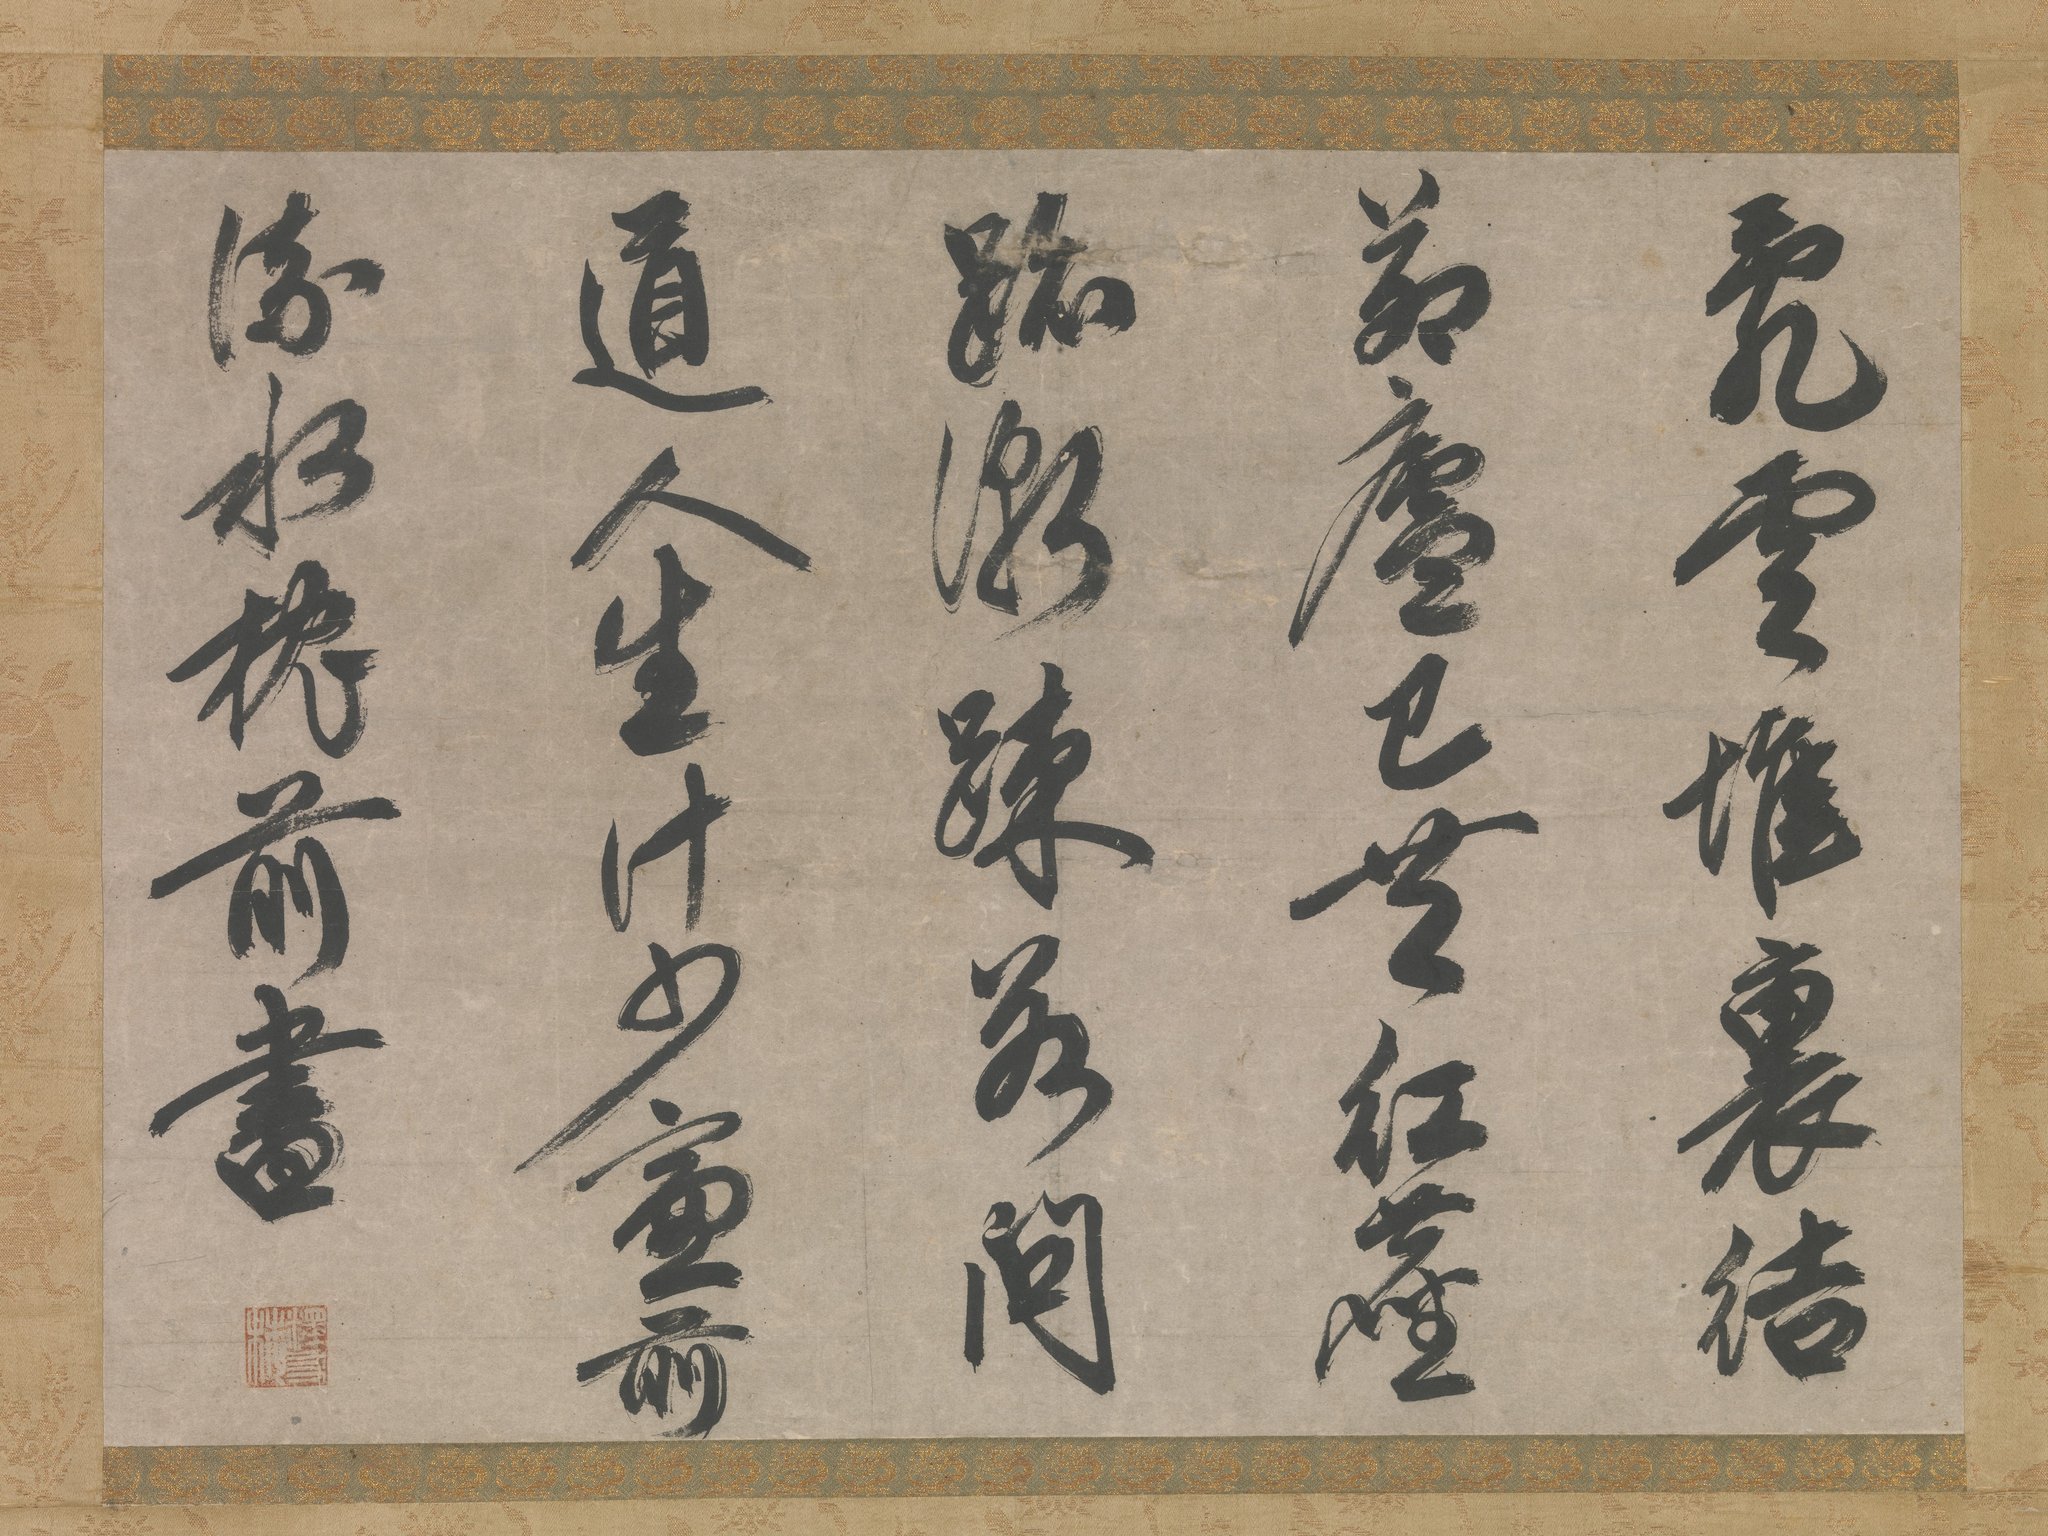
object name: hanging scroll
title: On Reclusion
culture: japanese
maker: sesson yūbai 雪村友梅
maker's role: artist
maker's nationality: japanese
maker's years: 1290-1346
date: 1301-1350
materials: ink, paper